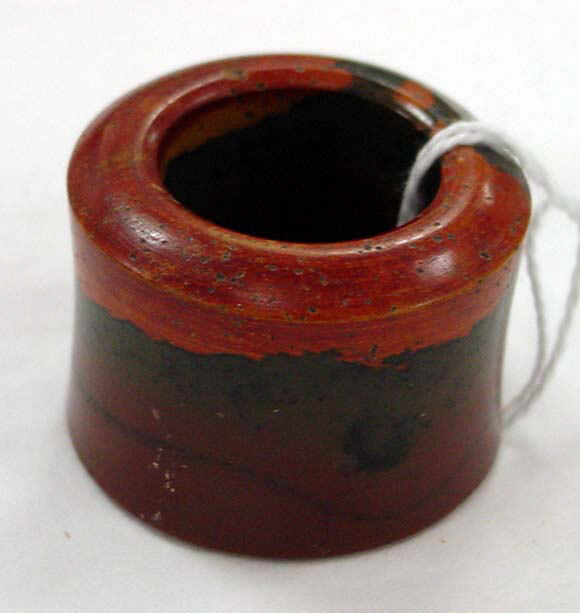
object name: ring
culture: chinese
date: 1801-1900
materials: stone